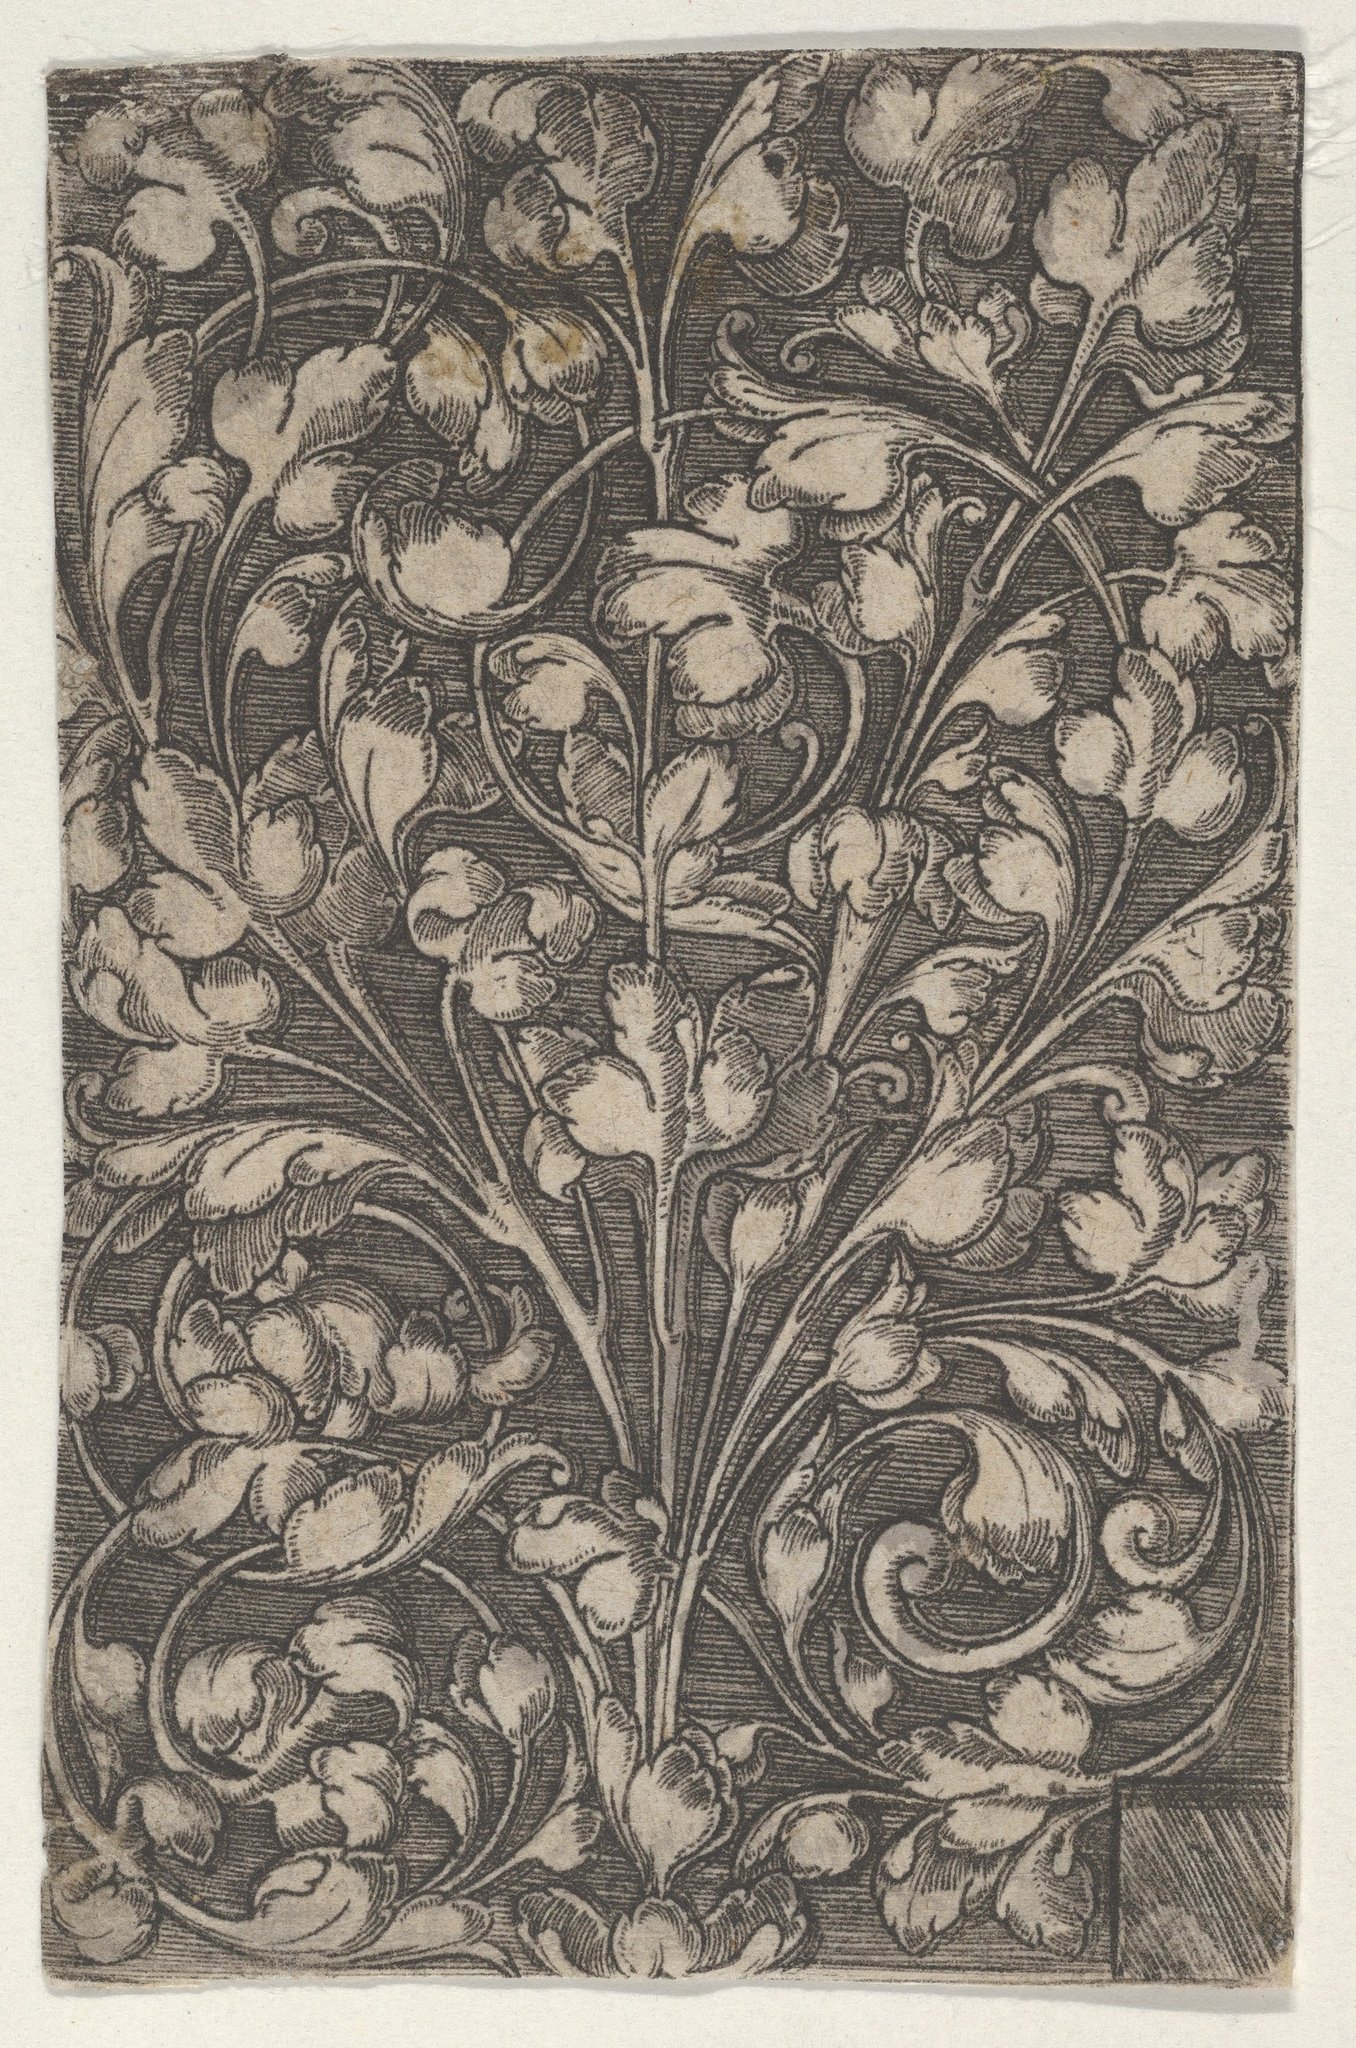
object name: print ornament architecture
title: Vertical Panel with Scrolling Tendrils Rising from Center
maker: heinrich aldegrever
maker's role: artist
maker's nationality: german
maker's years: 1502-1561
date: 1517-1561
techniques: engraving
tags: leaves